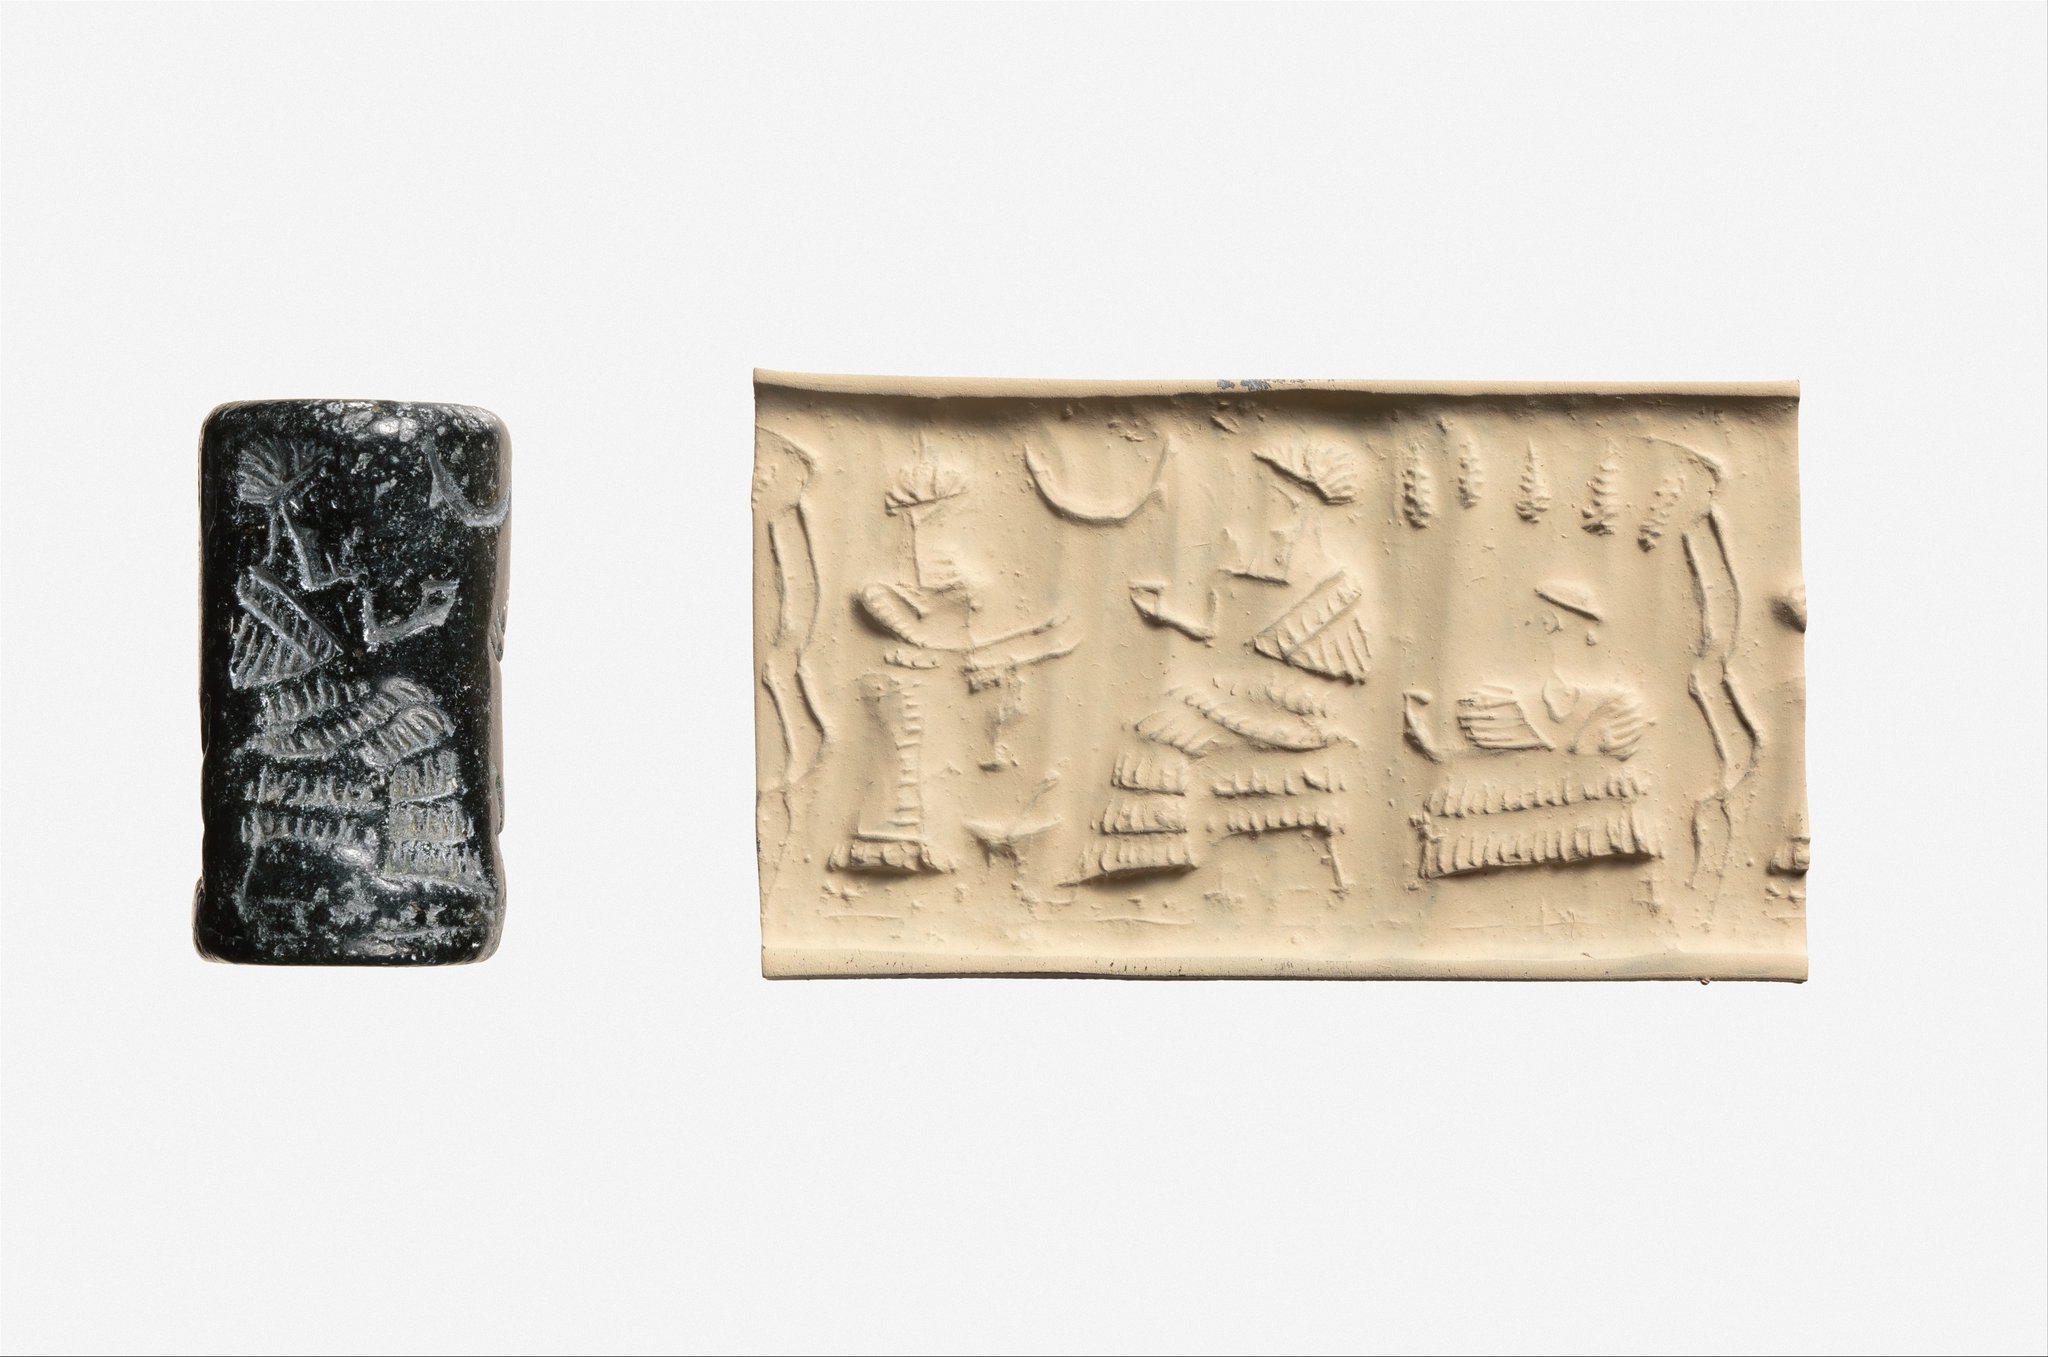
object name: cylinder seal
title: Cylinder seal and modern impression: worshiper before a seated ruler or deity; seated female under a grape arbor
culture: elamite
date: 2000-1668 BCE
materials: stone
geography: iran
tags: women